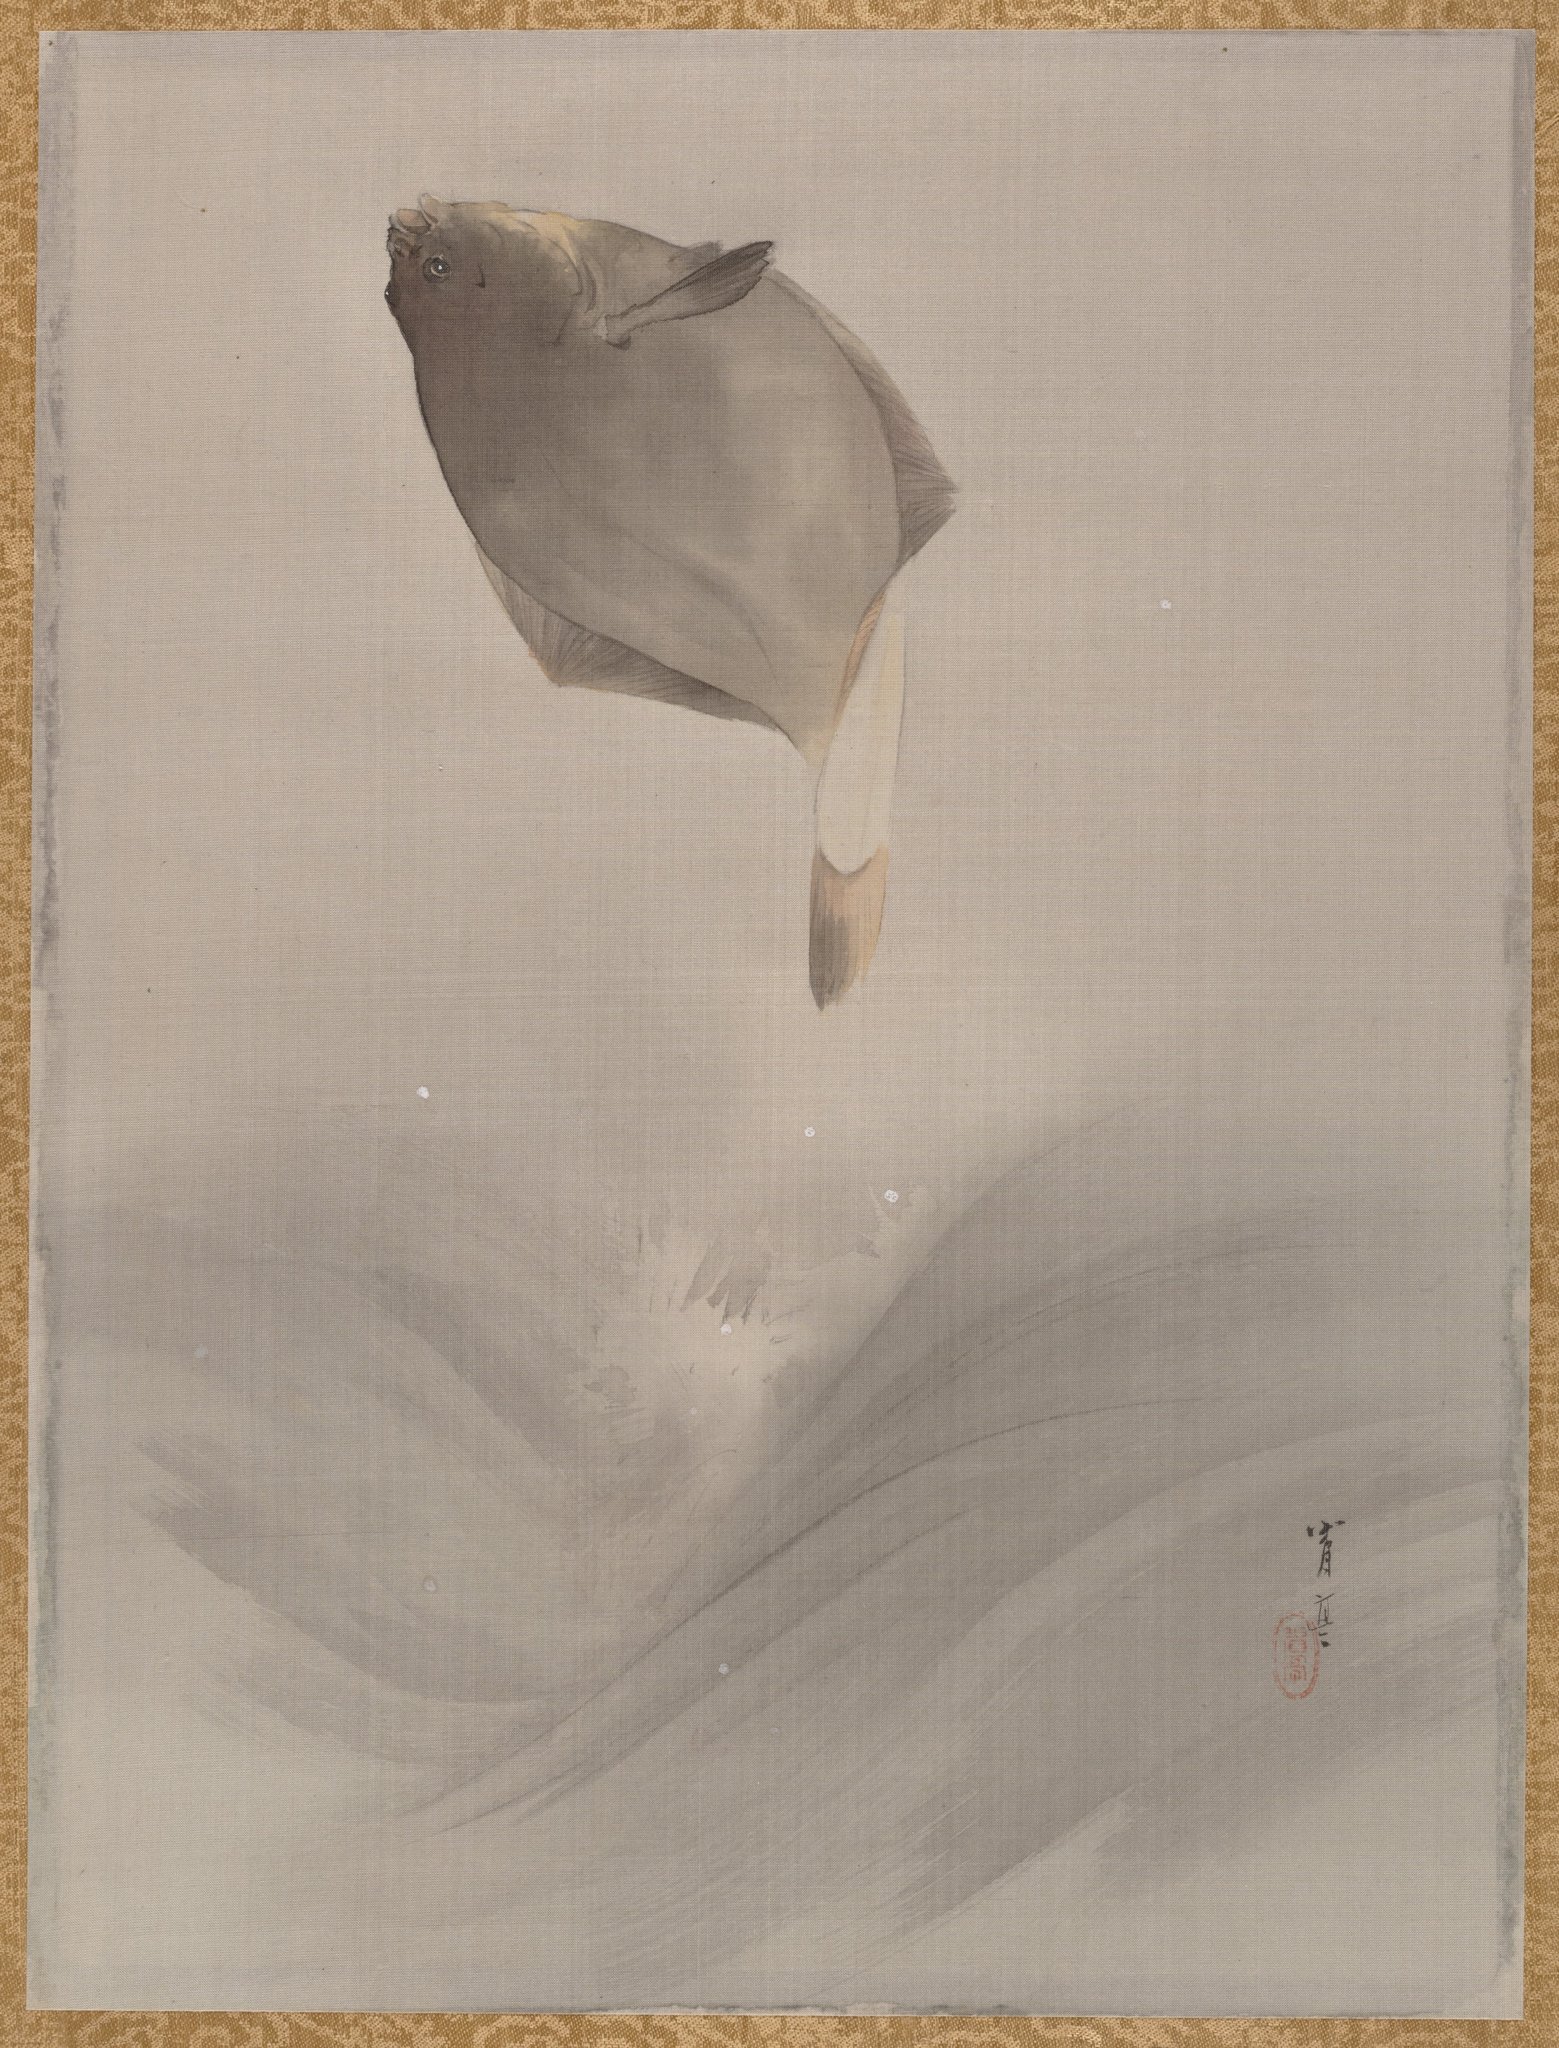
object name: album leaf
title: Jumping fish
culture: japanese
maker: watanabe seitei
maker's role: artist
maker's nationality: japanese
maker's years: 1851-1918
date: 1887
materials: ink, silk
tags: fish